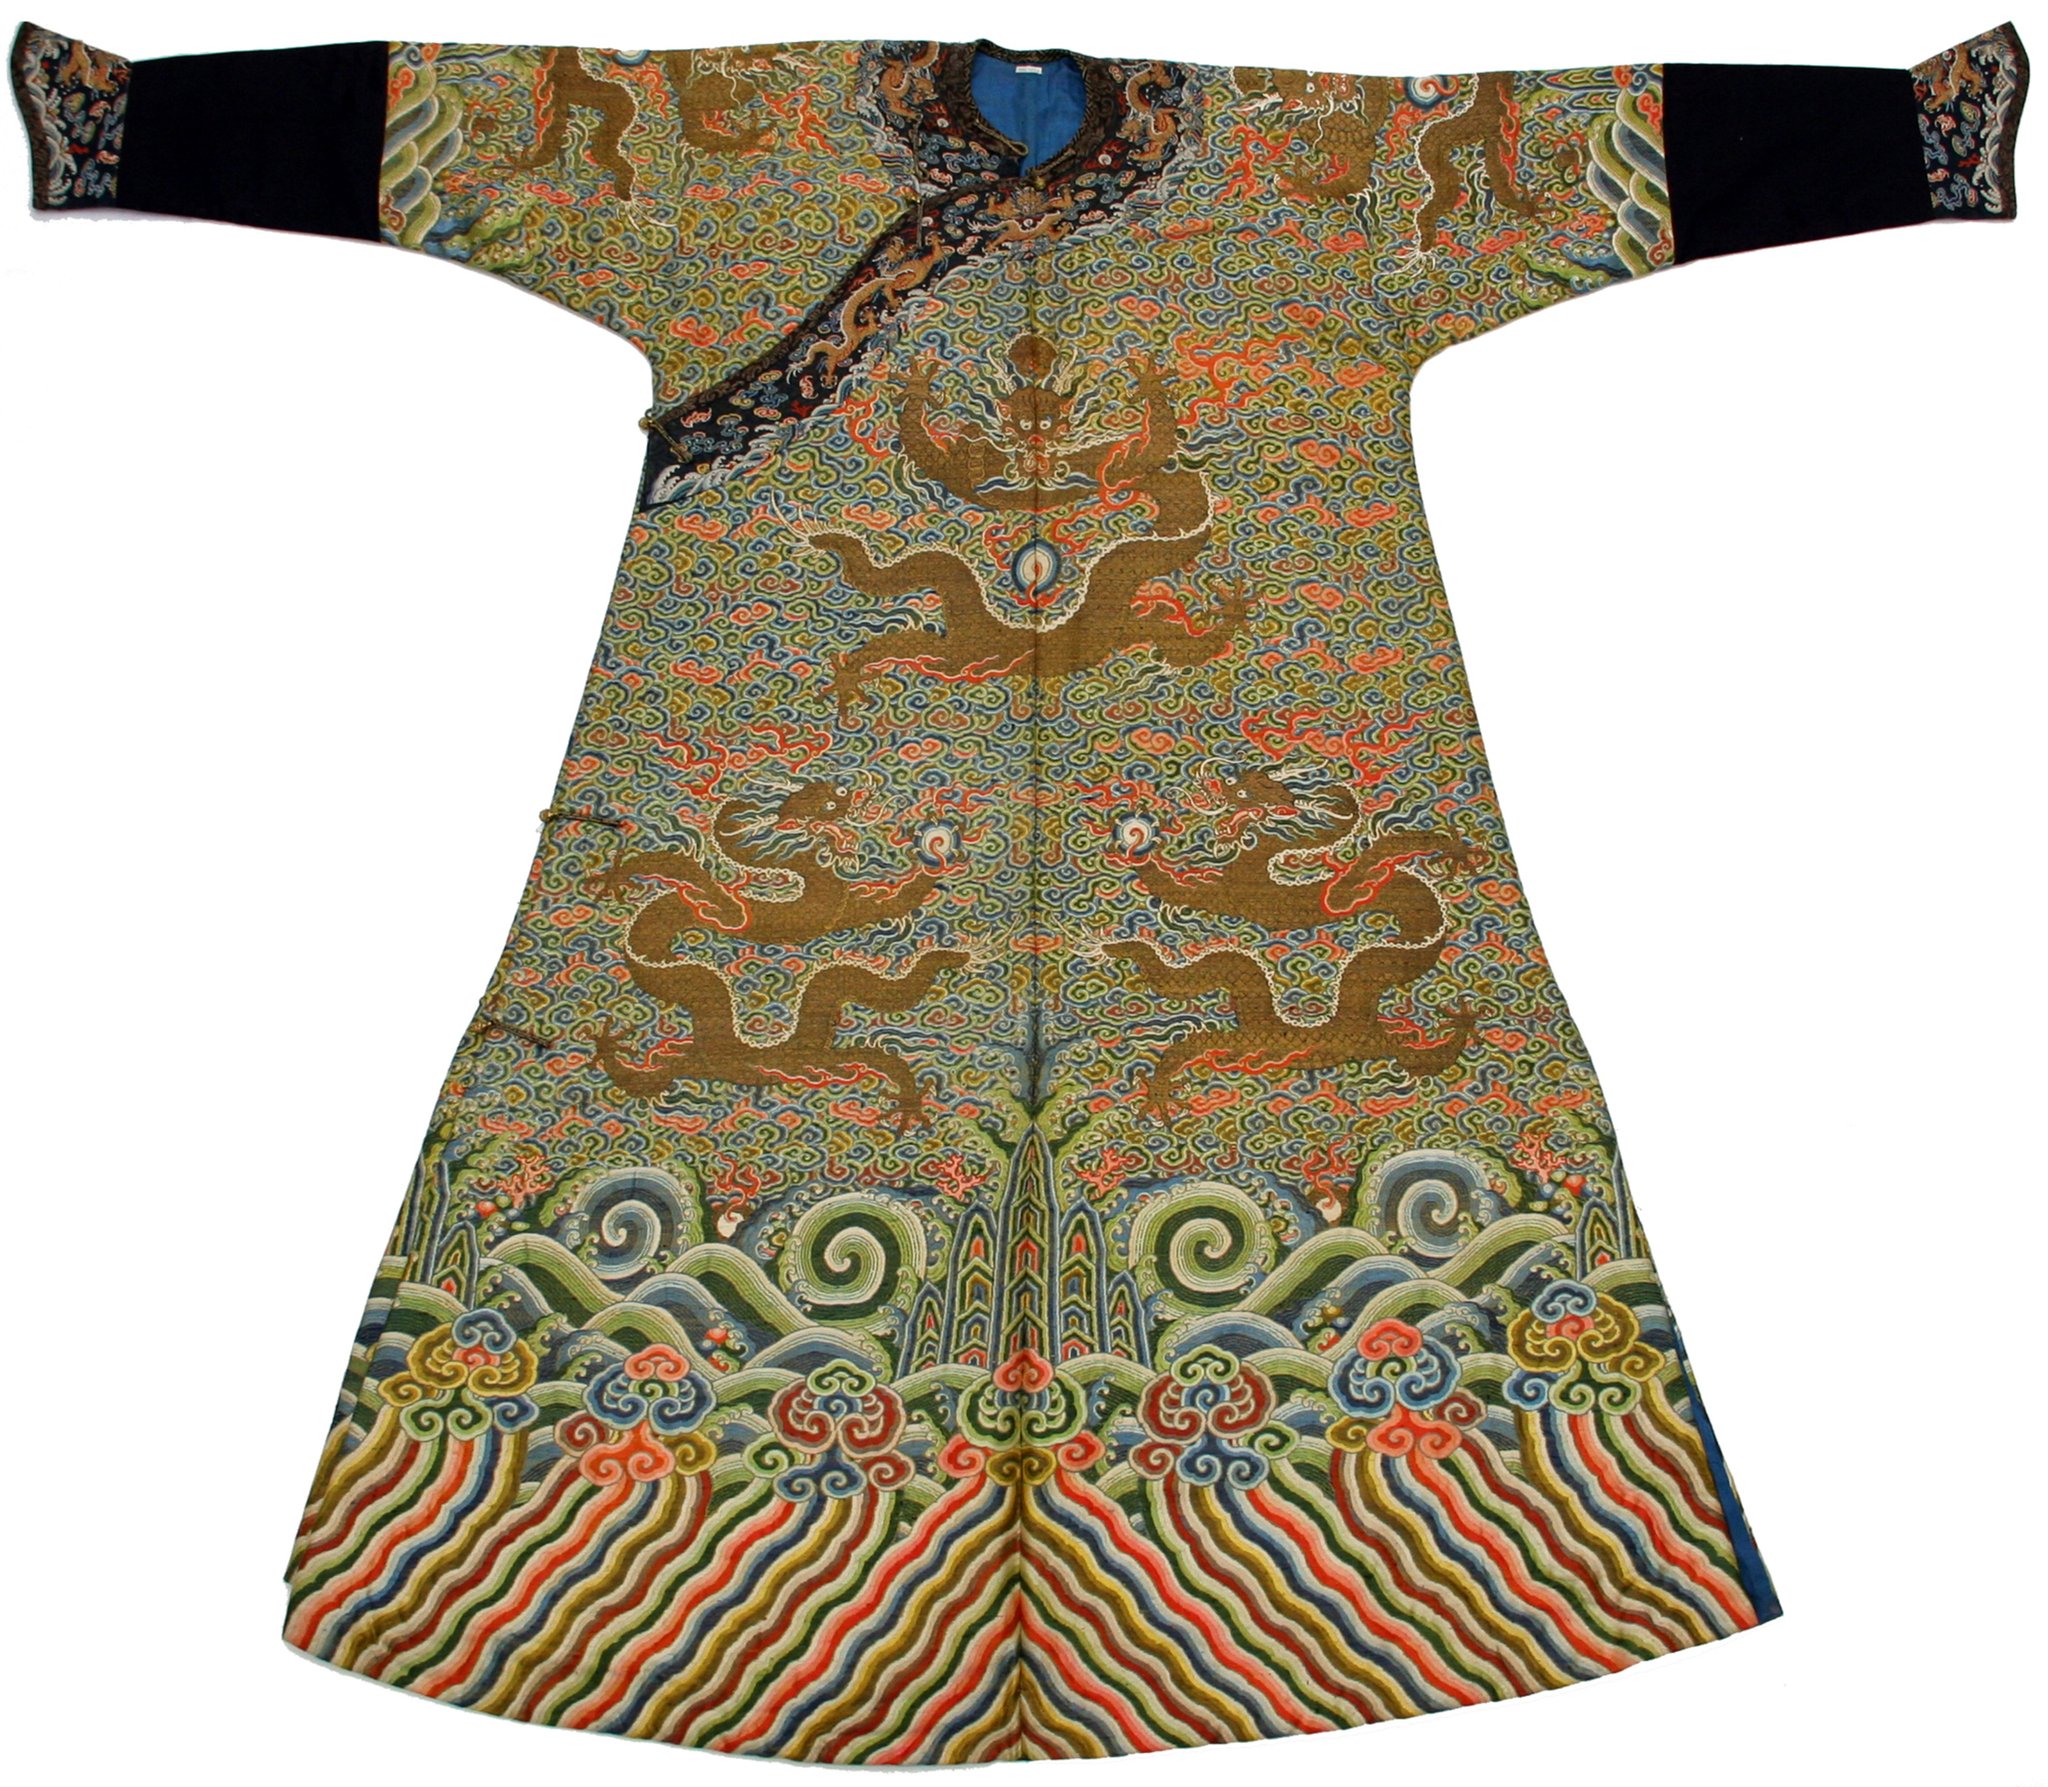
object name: dragon robe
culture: chinese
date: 1701-1800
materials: metal thread, silk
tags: dragons